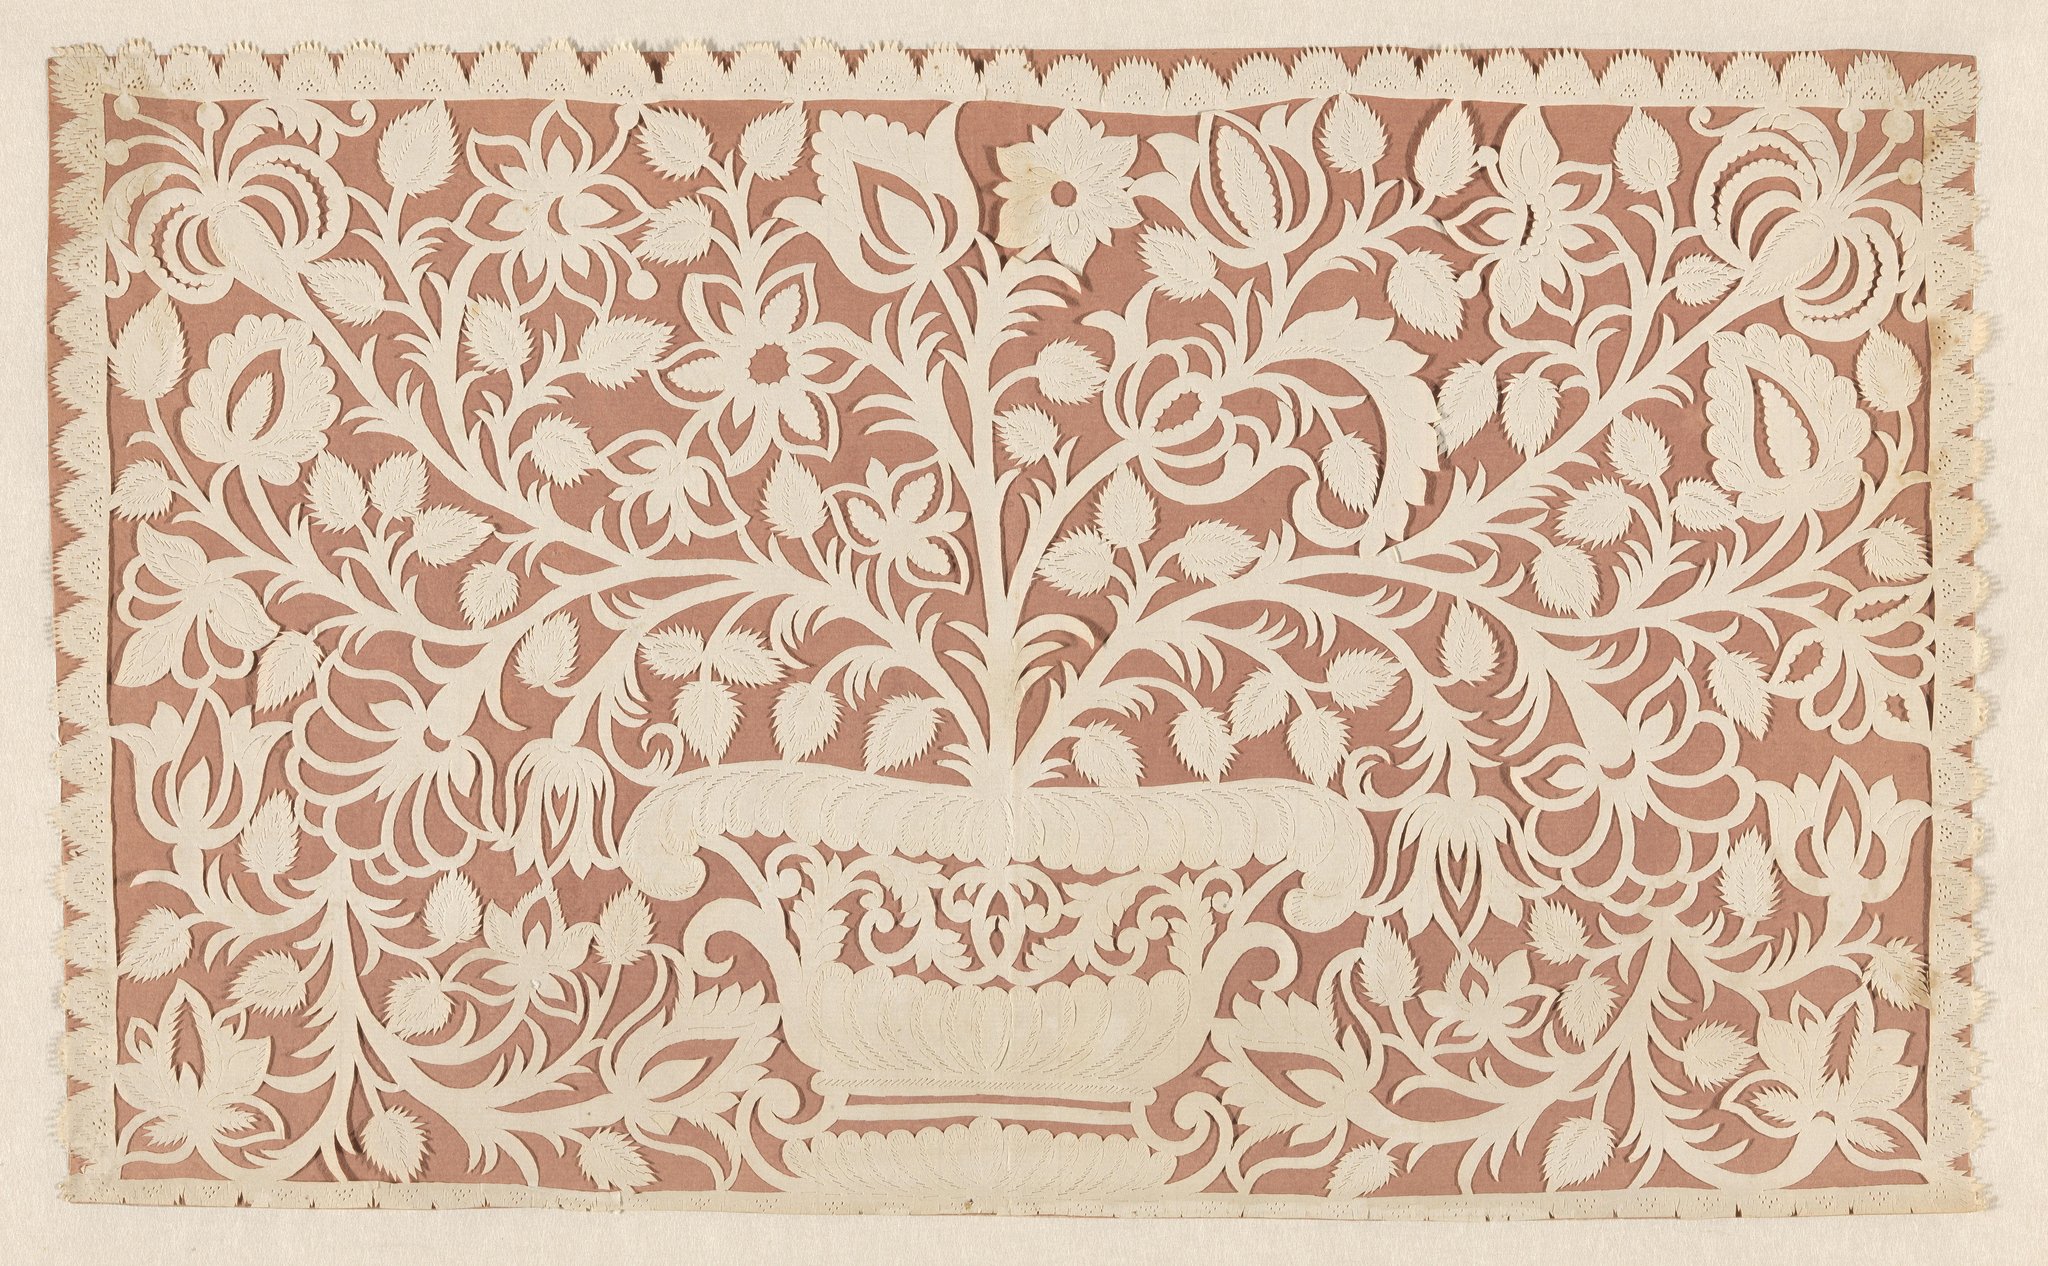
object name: cut paper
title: Sierstuk met vaas en bloemen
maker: Anonymous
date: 1740-1770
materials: paper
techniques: cutting, snipping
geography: netherlands